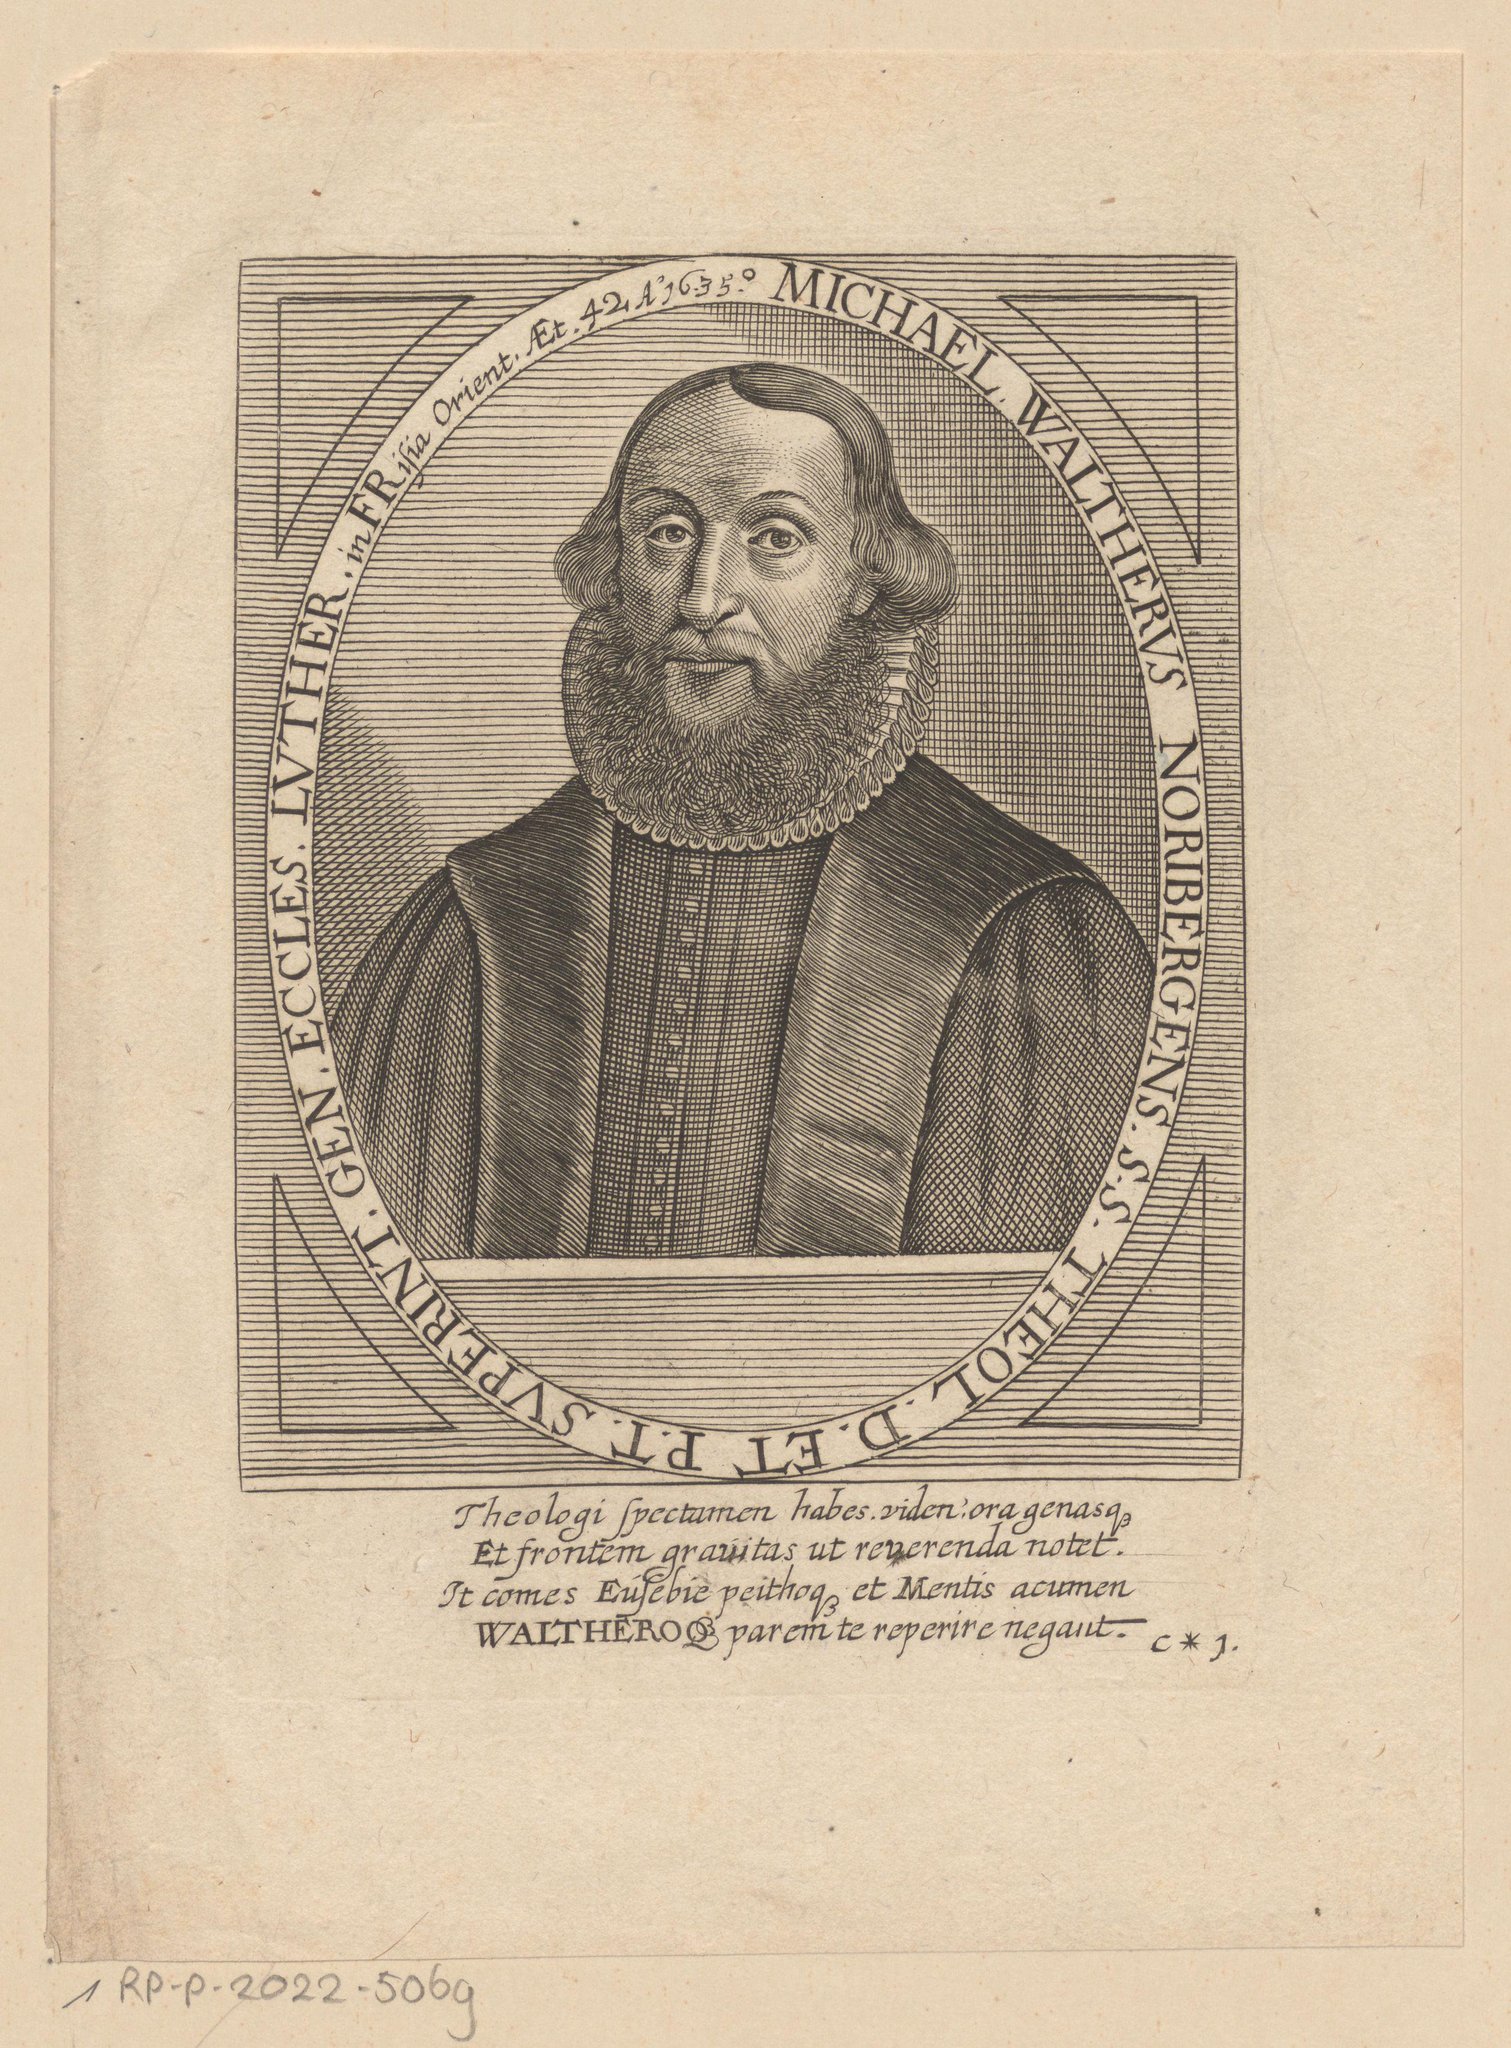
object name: print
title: Bibliotheca chalcographica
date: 1654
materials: paper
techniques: engraving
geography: heidelberg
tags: theologian, historical persons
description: Prent uit: Boissard, Jean Jacques. Bibliotheca chalcographica hoc est virtute et eruditione clarorum virorum imagines. Heidelberg: Johann Ammon, 1654, dl. 9.